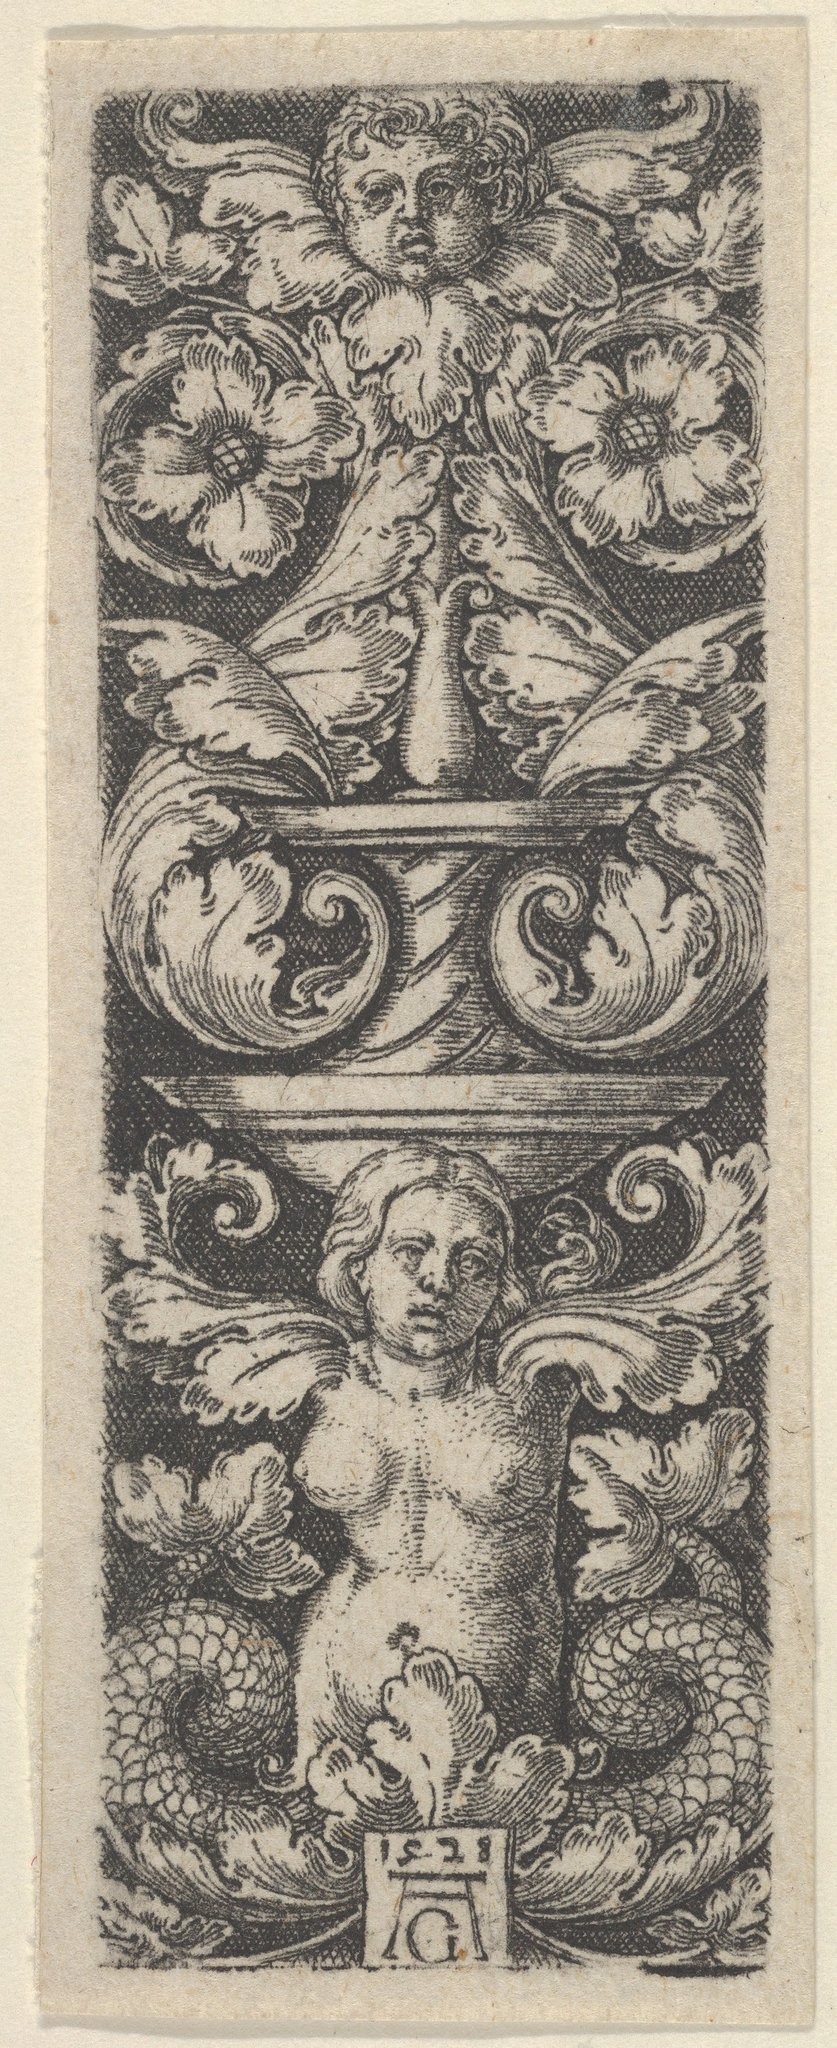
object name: print ornament architecture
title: Vertical Panel with a Candelabrum Containing a Child's Head and a Woman with Two Fish Tails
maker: heinrich aldegrever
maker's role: artist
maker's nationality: german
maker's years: 1502-1561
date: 1528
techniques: engraving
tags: heads,children,female nudes